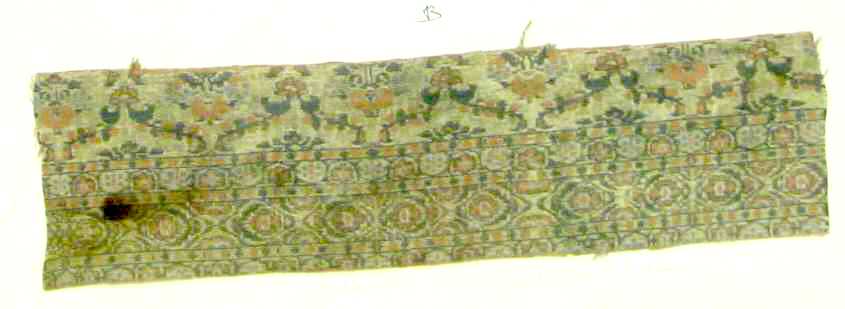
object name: textile fragment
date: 1601-1700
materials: silk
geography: iran